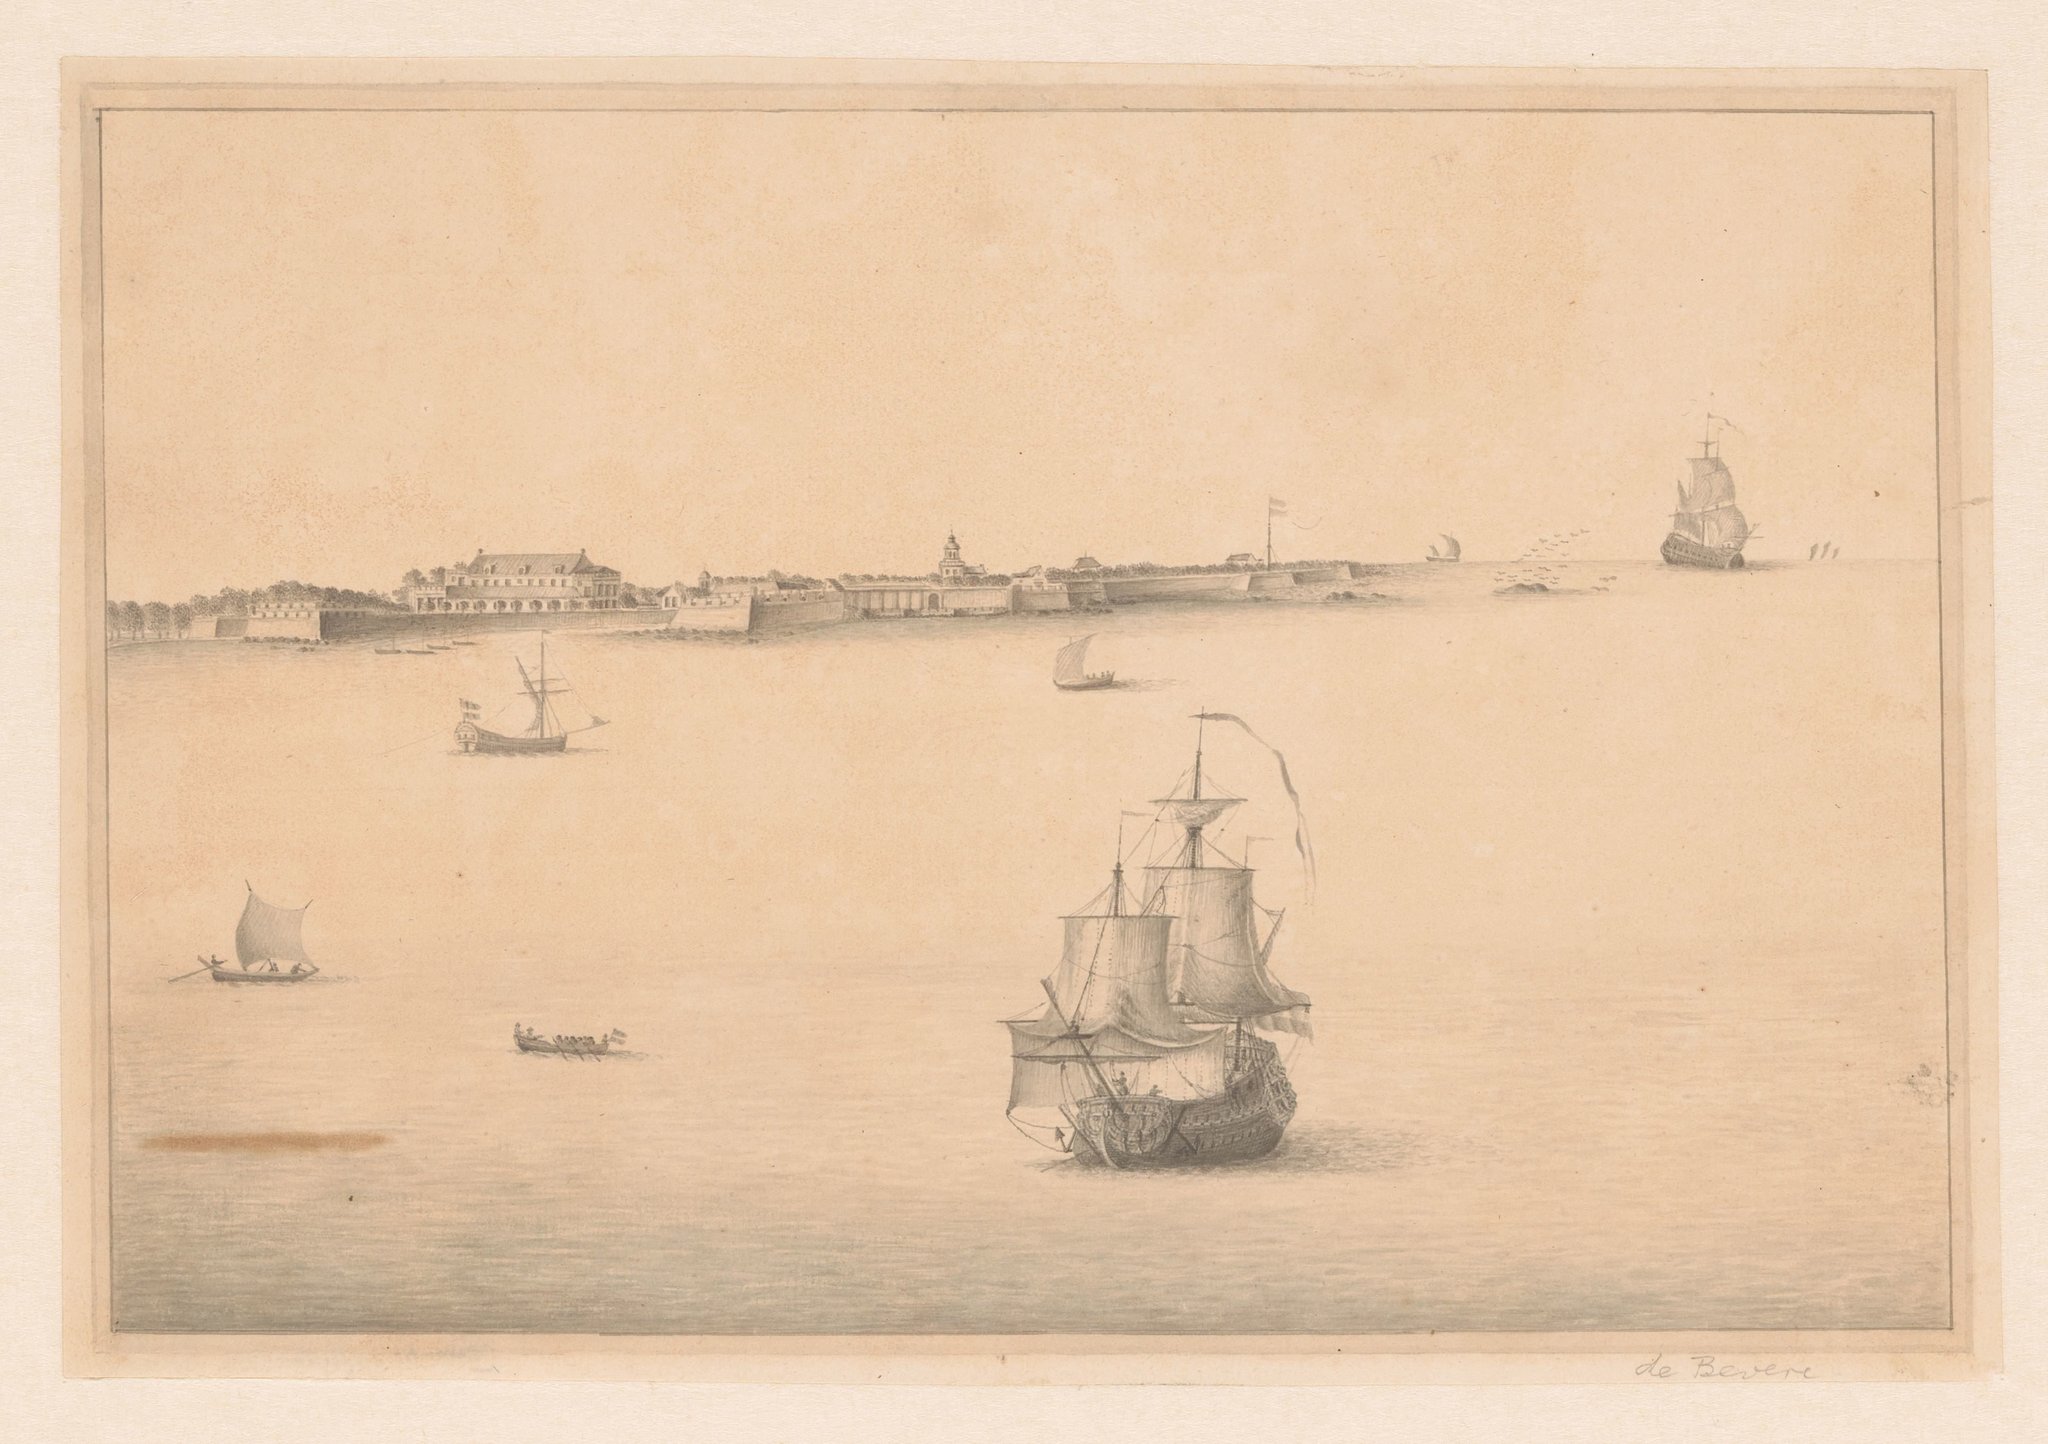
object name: drawing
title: View of Colombo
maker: pieter de bevere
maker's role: draughtsman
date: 1755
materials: graphite, ink, paper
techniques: brush, pen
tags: prospect of city, town panorama, silhouette of city, sri lanka